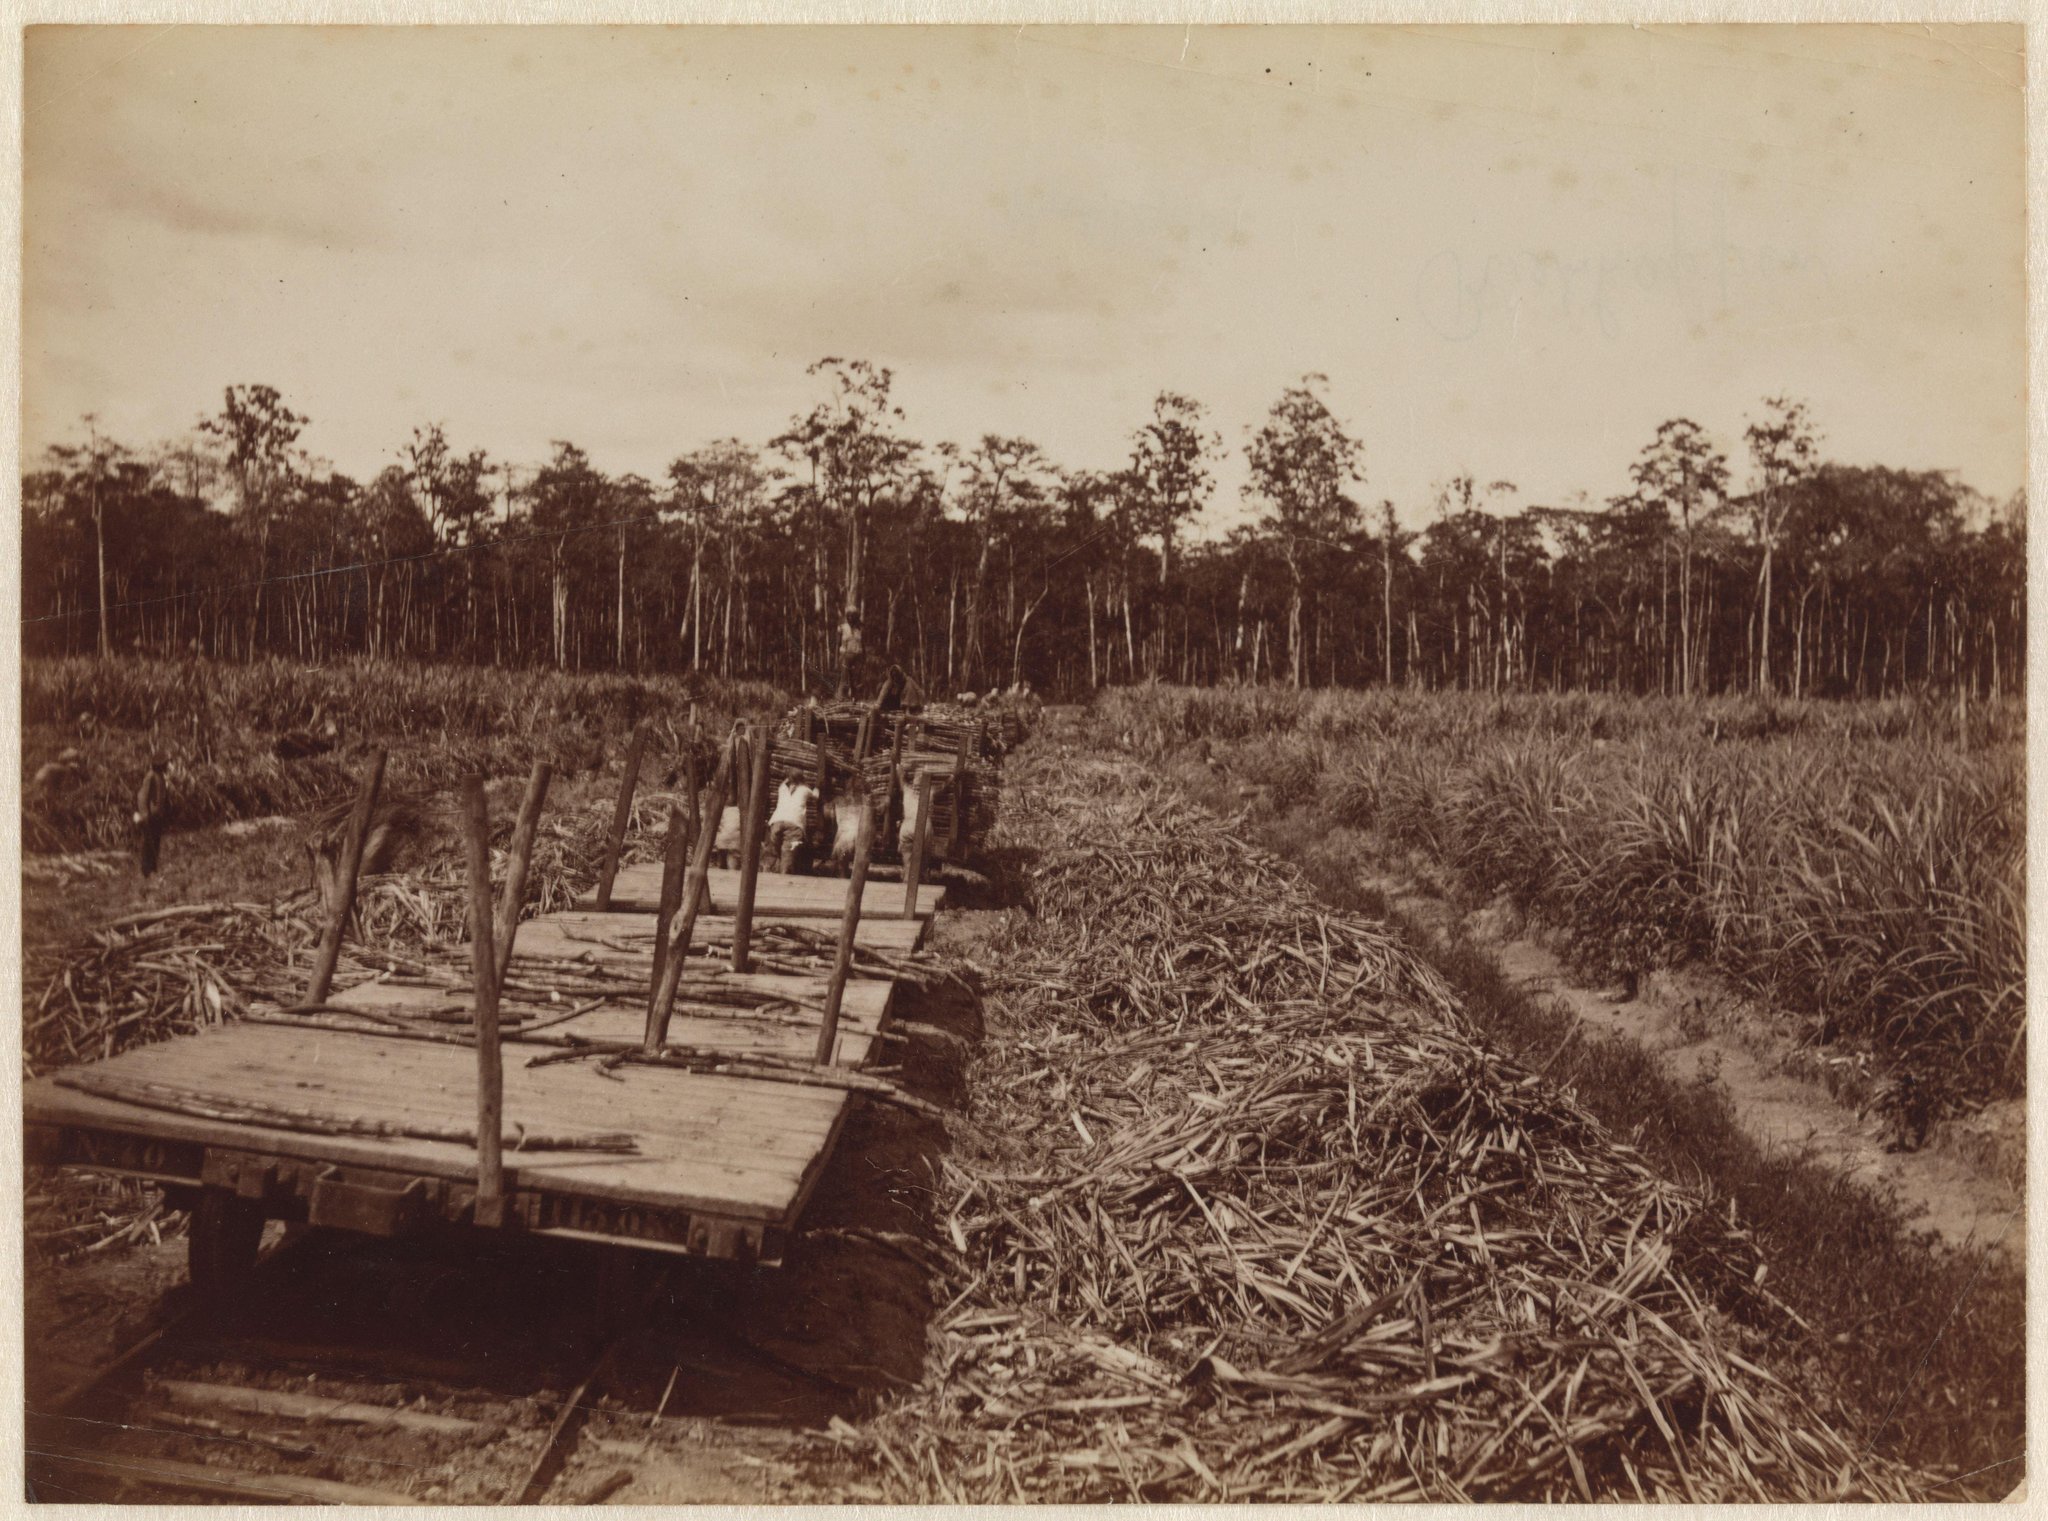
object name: photograph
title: Rietkappen op usine marienburg het ..oogsten van suikerriet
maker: julius muller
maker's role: official, politician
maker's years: 1846-1902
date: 1882-1902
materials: photographic support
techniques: albumen print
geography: suriname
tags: plantation, plants and herbs: sugarcane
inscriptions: inscription: ‘Rietkappen op usine marienburg het ..oogsten van suikerriet’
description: Rietkappen op suikerplantage Marienburg in Suriname. Zichtbaar is de rails met de karren waarop het riet van het land naar de fabriek werd gereden.